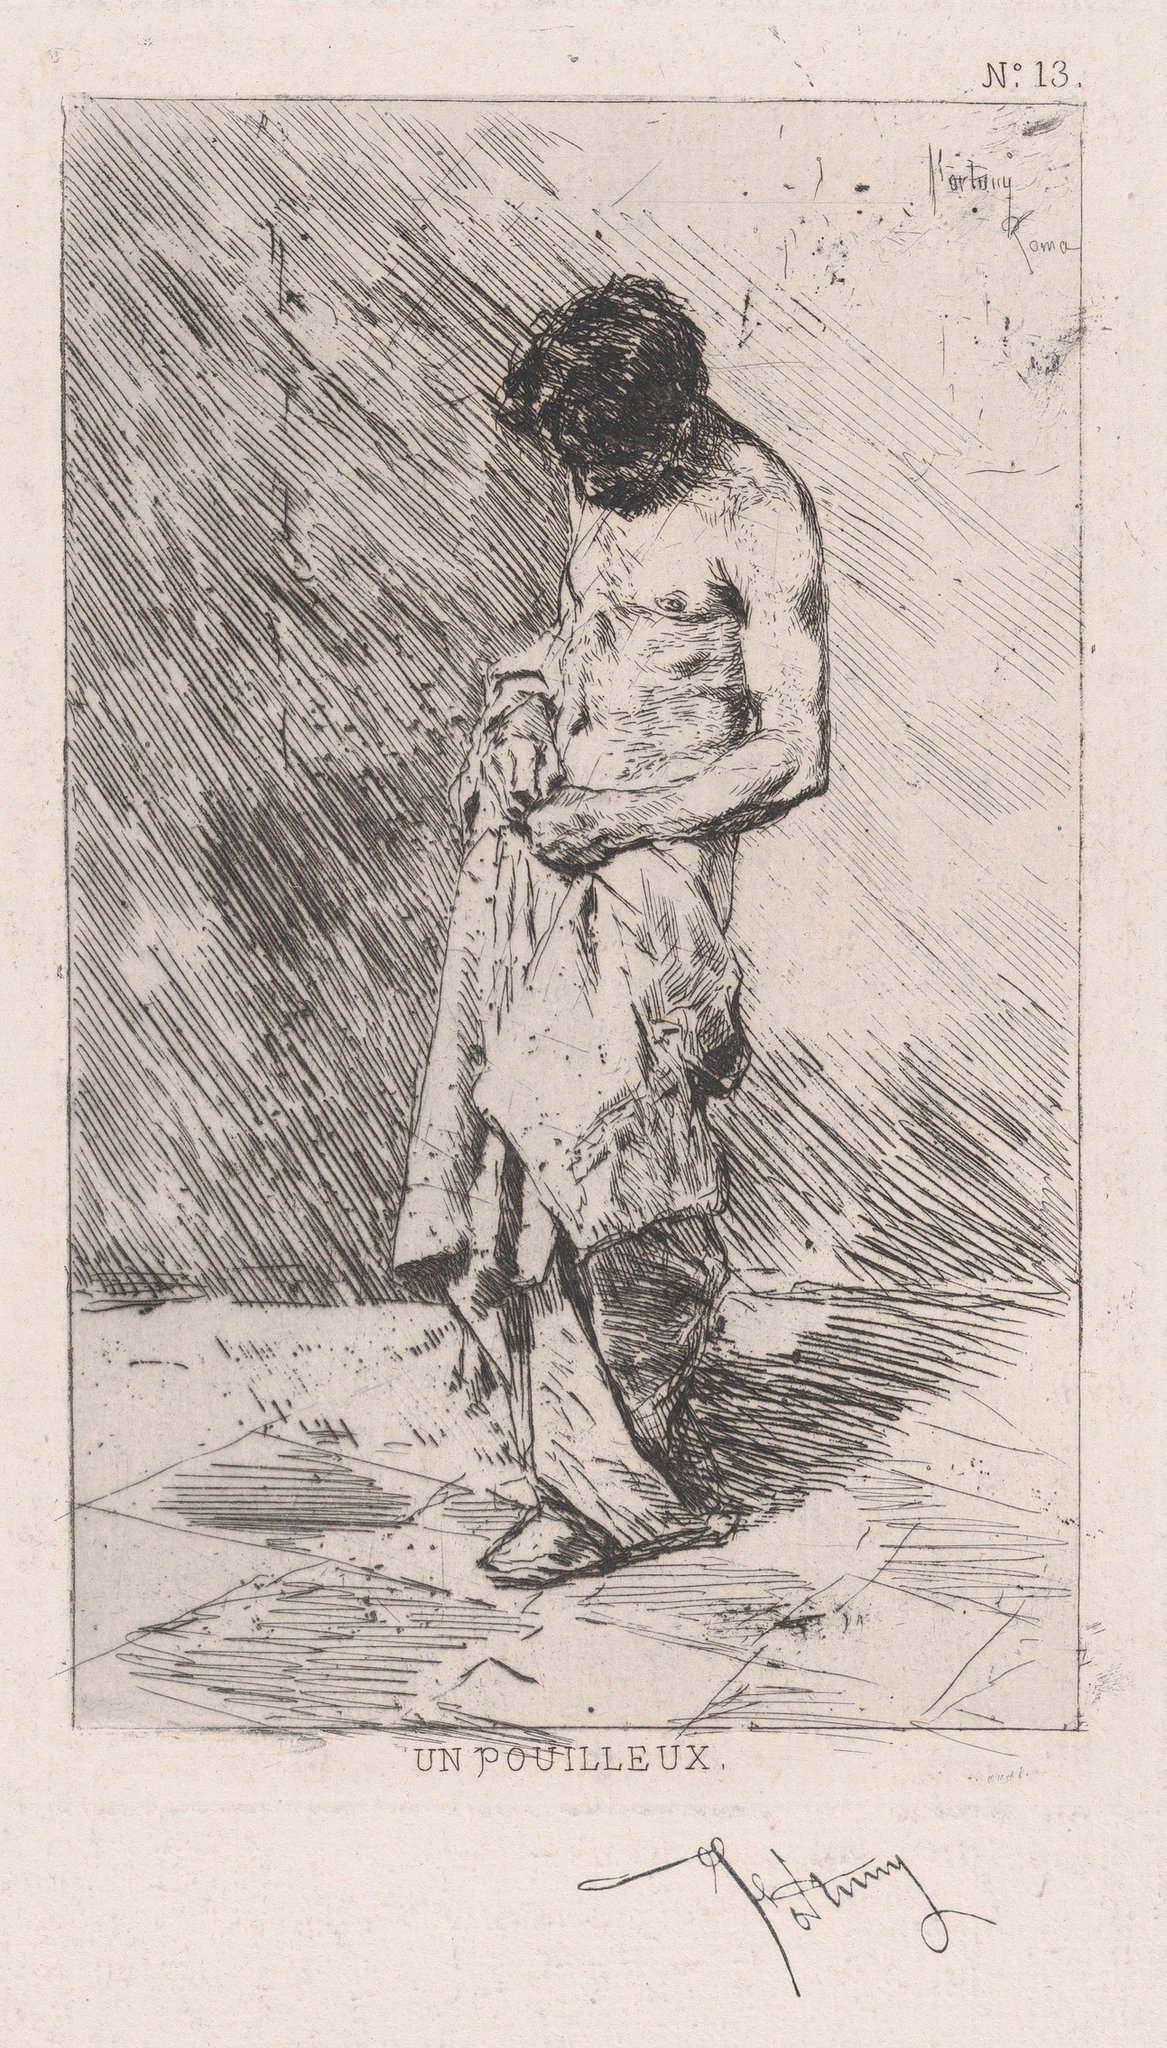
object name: print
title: Young man standing dressed in rags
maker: mariano fortuny, 1838–1874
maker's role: artist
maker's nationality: spanish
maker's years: 1838-1874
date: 1860-1870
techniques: etching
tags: men